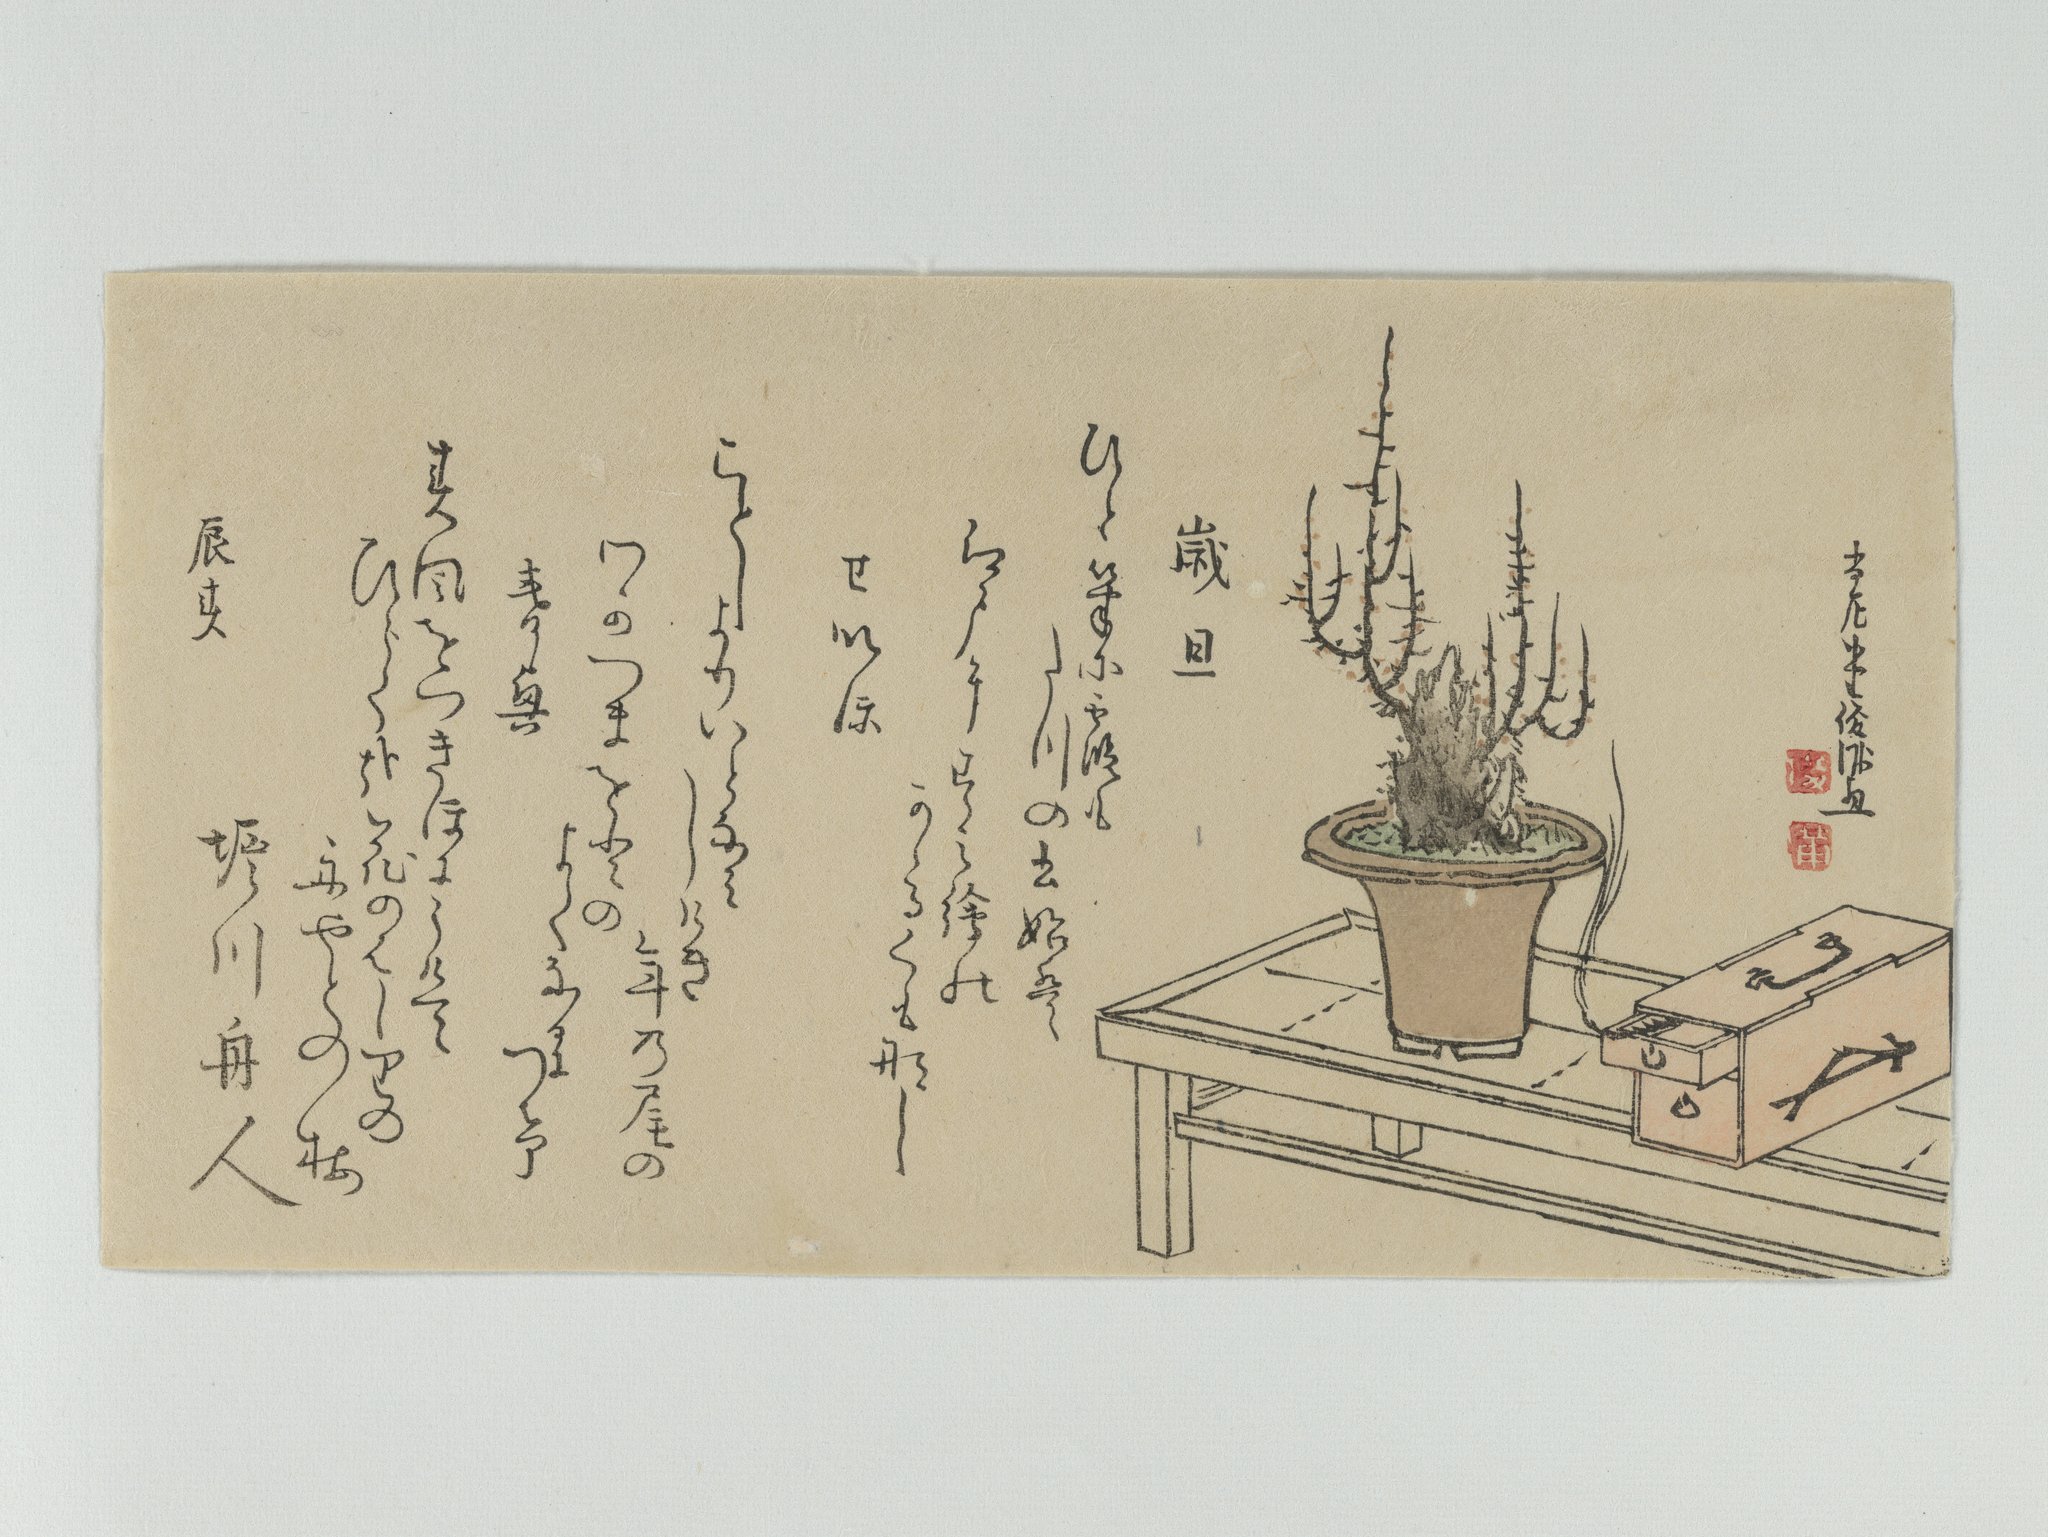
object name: woodblock print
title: Bonsai Plum Tree on Bench and Box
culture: japanese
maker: kubo shunman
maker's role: artist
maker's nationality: japanese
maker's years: 1757-1820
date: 1796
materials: ink, paper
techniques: surimono, woodblock print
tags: plants,benches